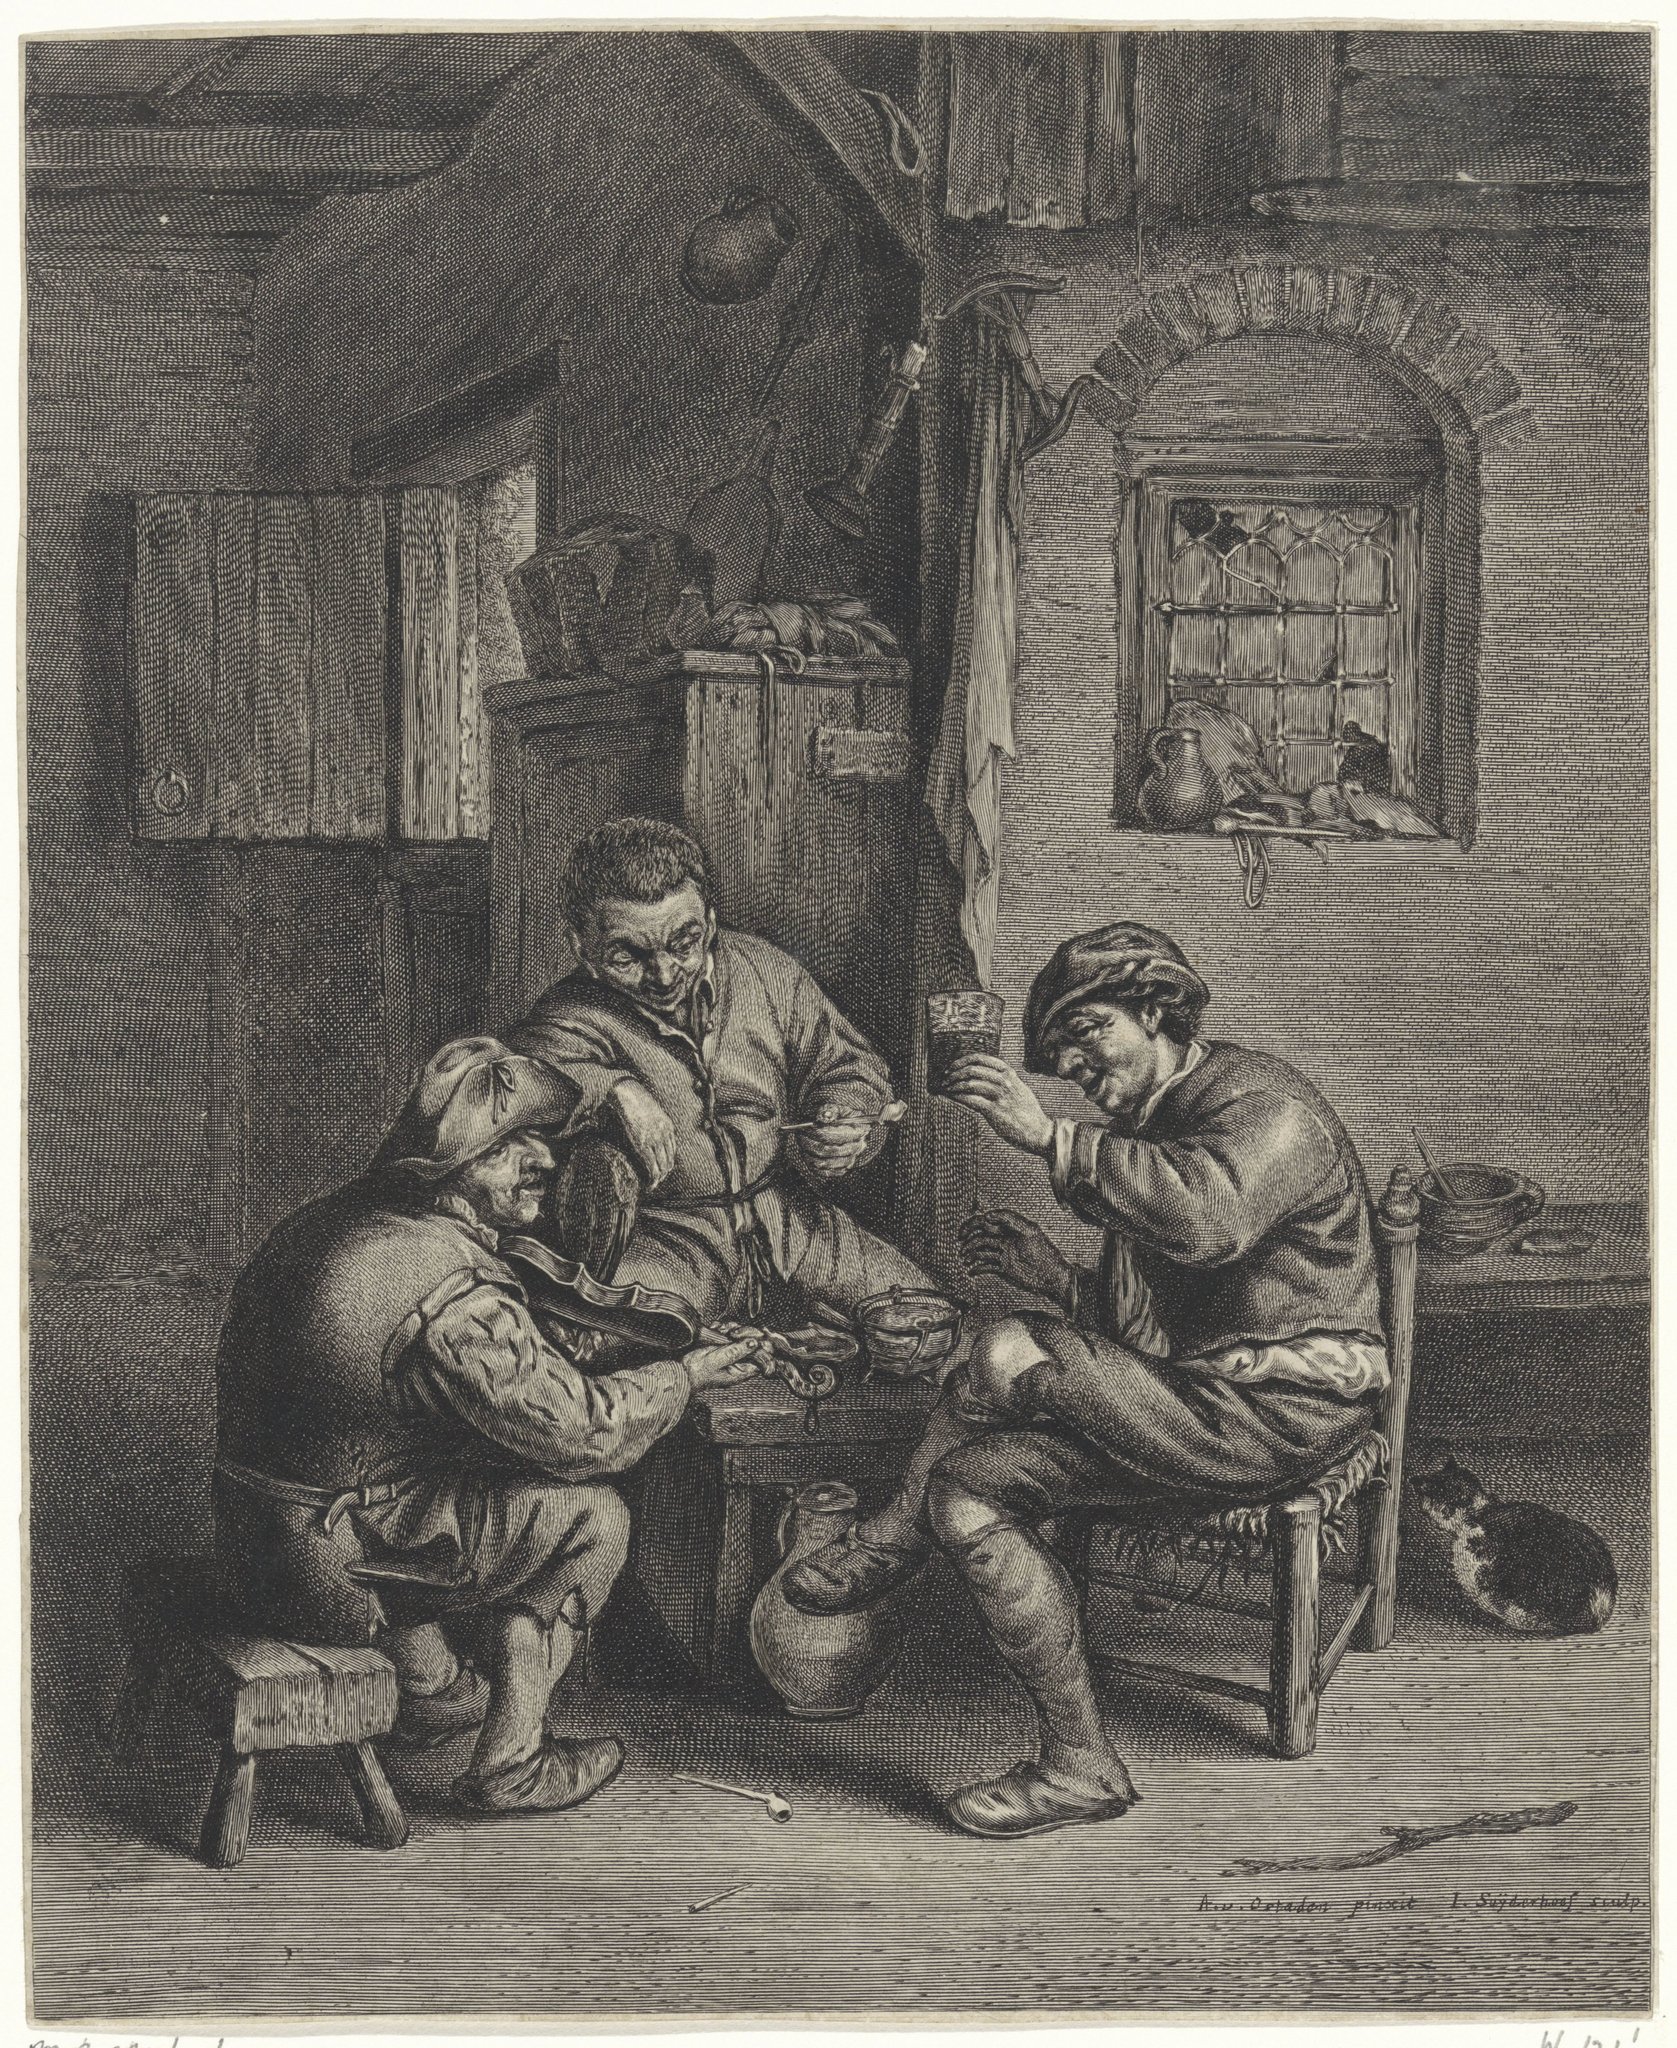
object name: print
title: Drie boeren zittend rond een bankje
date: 1647-1652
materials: paper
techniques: engraving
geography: haarlem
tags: violin, fiddle, pipe ~ tobacco, interior of the house, glass, rummer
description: Interieur met drie boeren, die rond een bankje zitten. De man links speelt viool, de man rechts heft het glas en de man in het midden houdt een pijp in de hand.